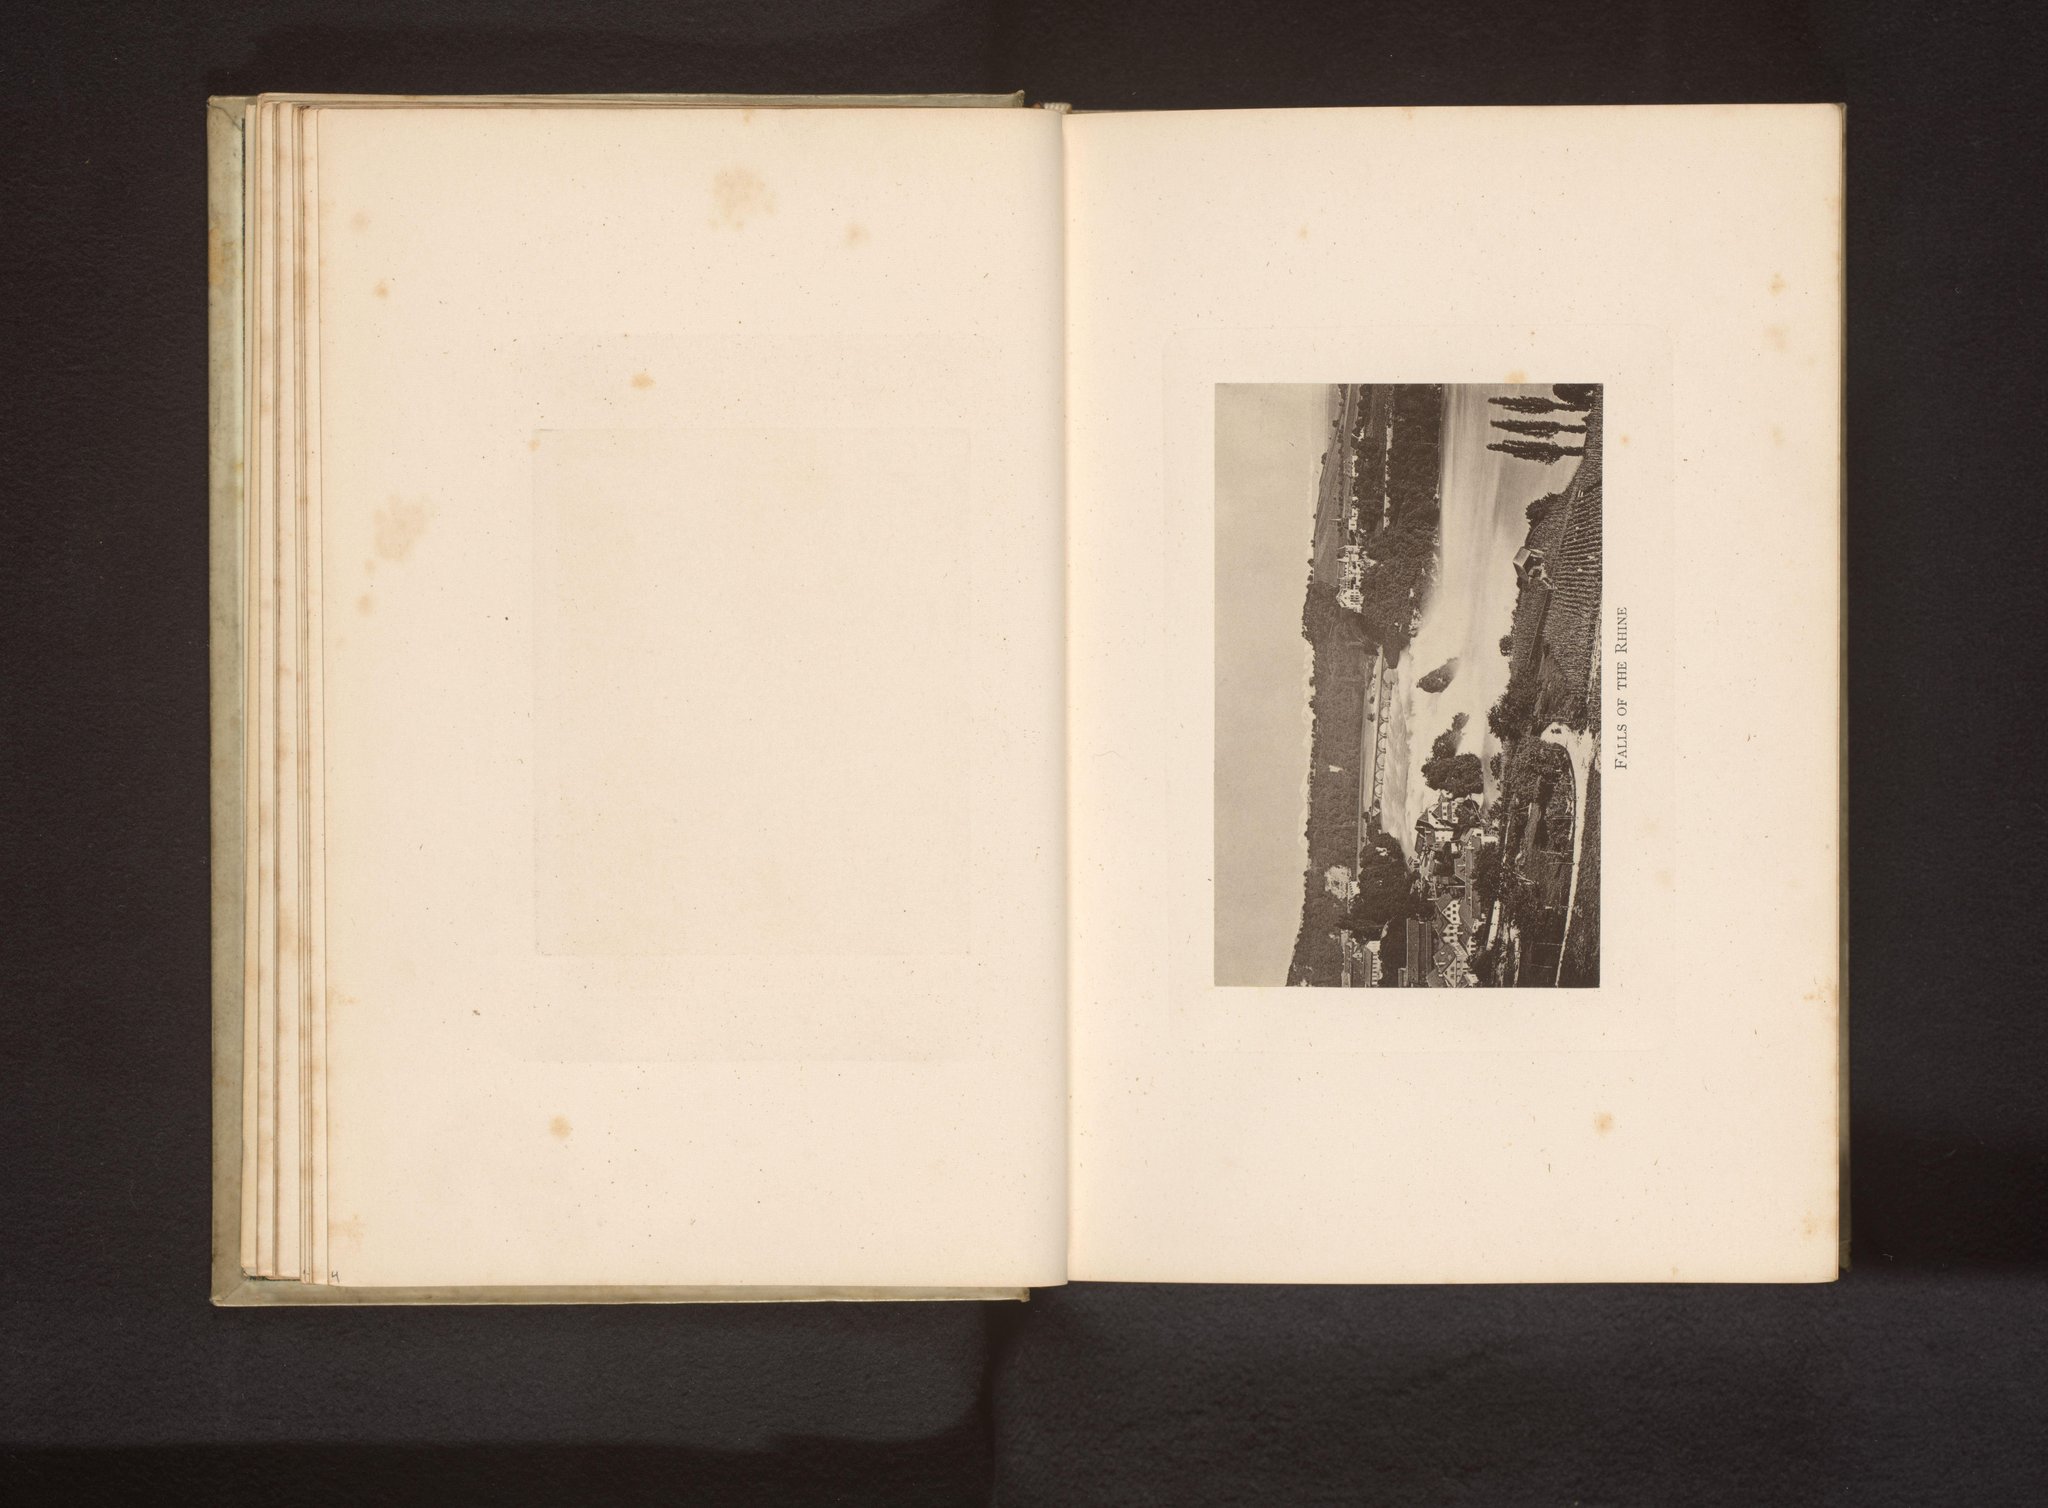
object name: page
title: Gezicht op de Rheinfall bij Schaffhausen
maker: Anonymous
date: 1874-1884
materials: paper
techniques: photograph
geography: schaffhausen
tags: waterfall